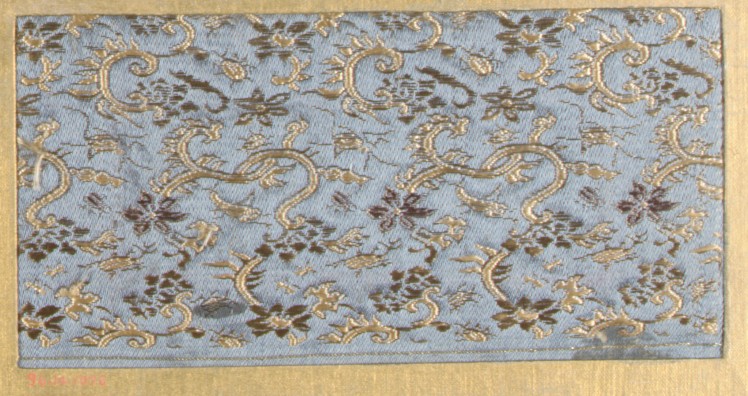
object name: piece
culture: japanese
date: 1701-1900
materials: silk